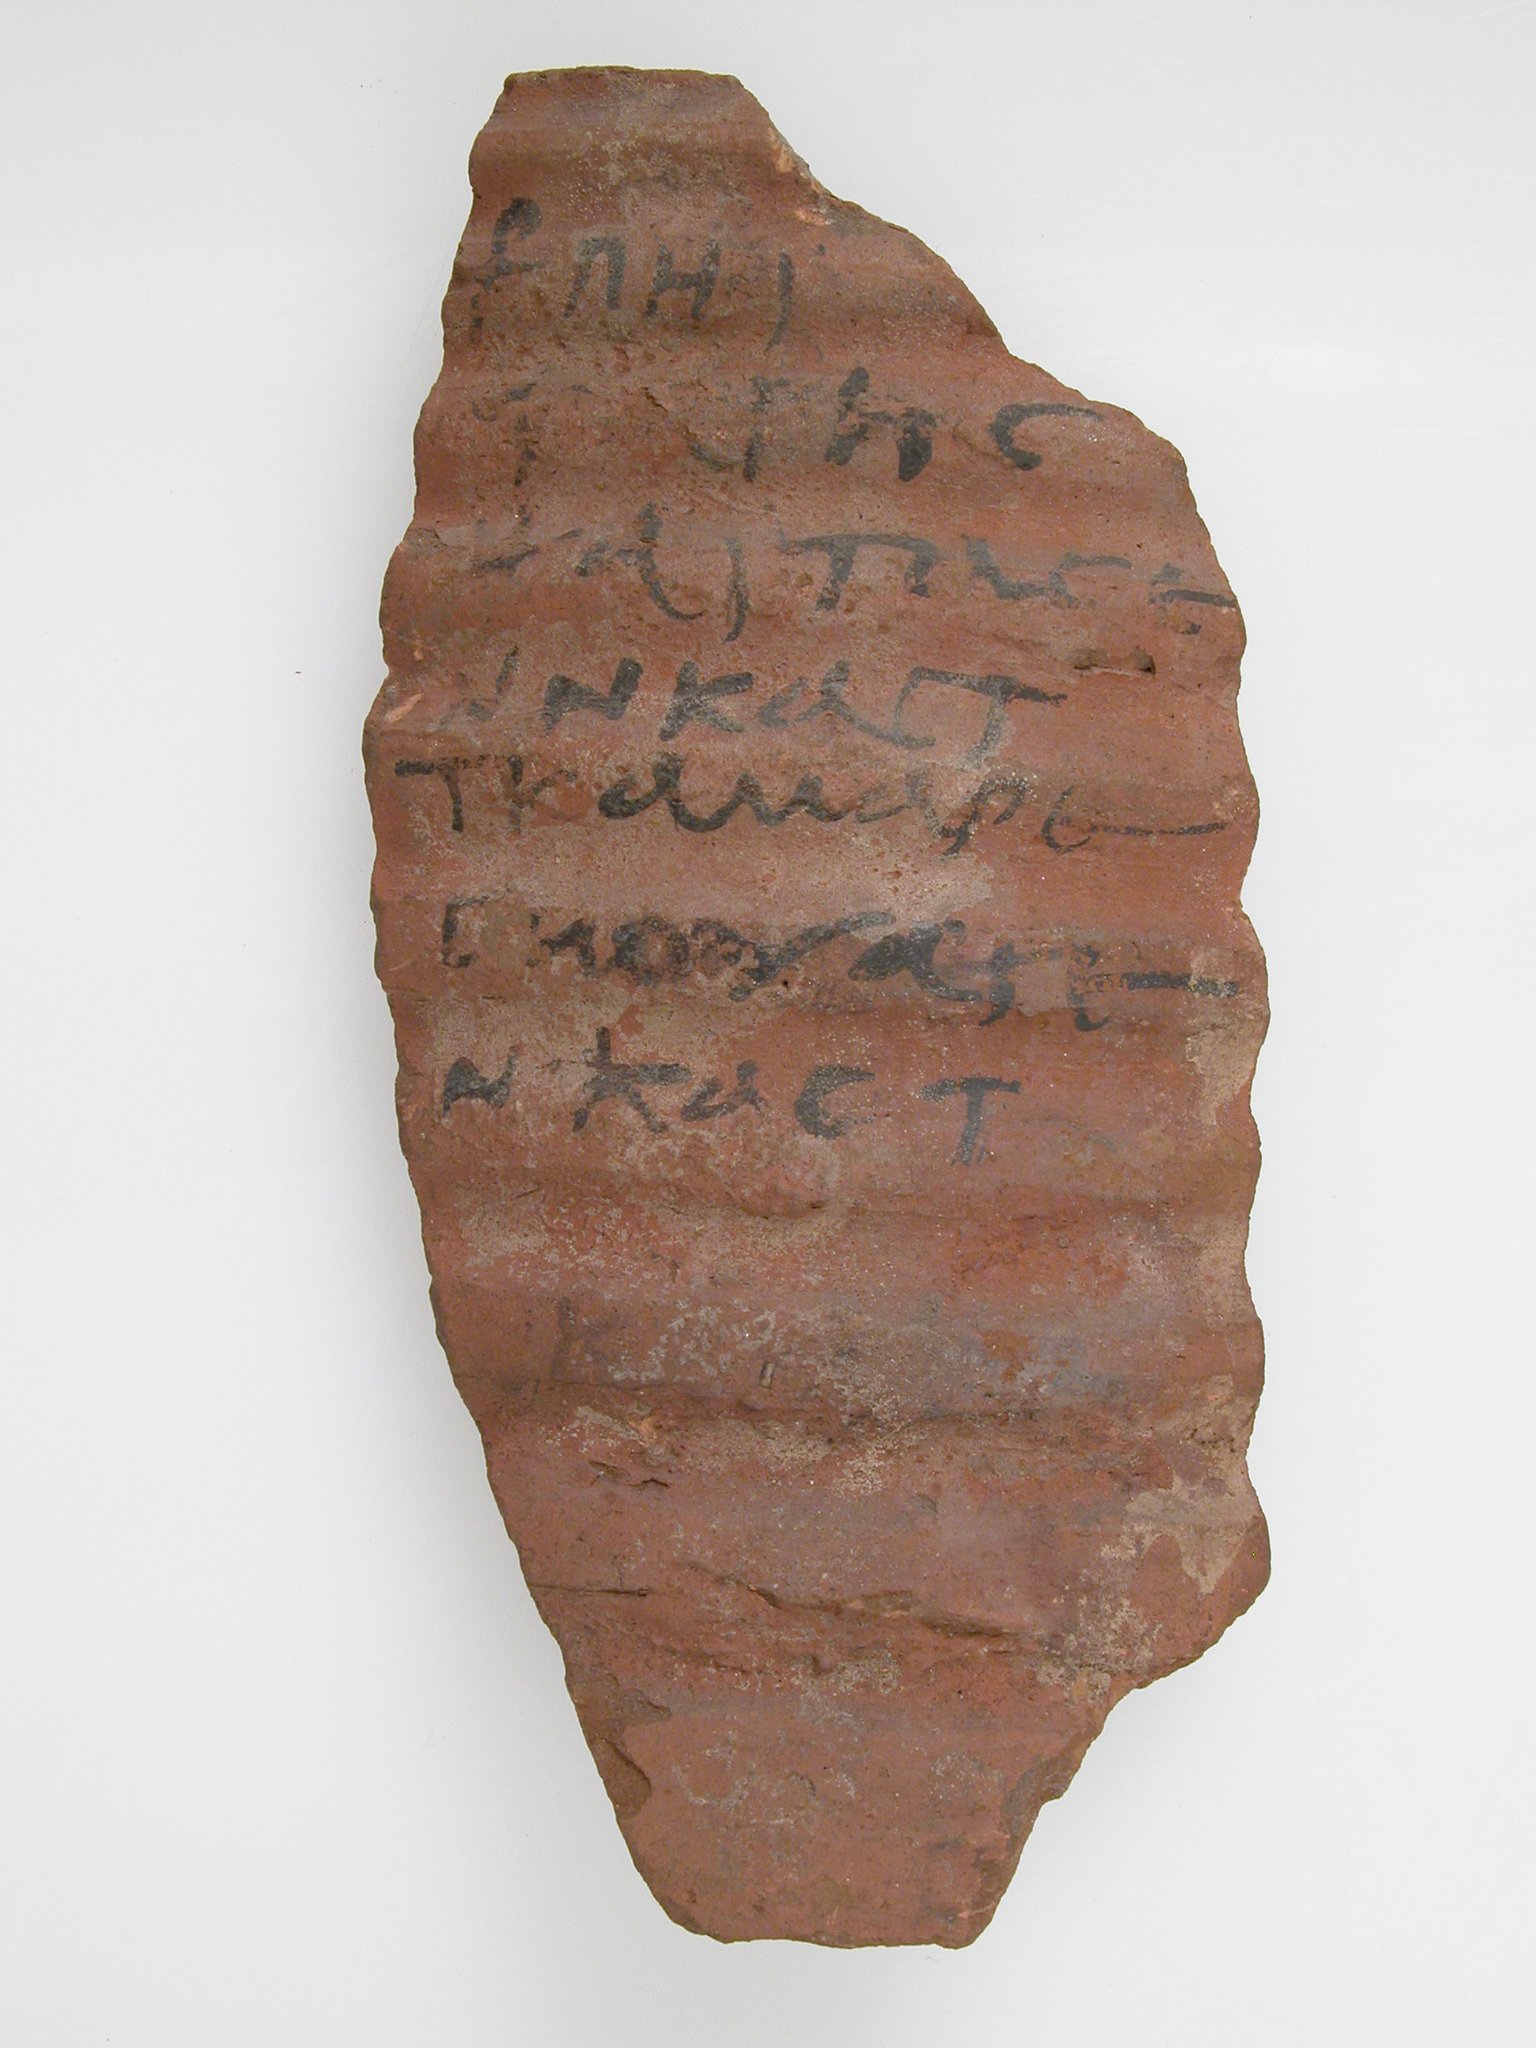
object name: ostrakon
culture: coptic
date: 601-700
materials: ink, pottery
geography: egypt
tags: documents